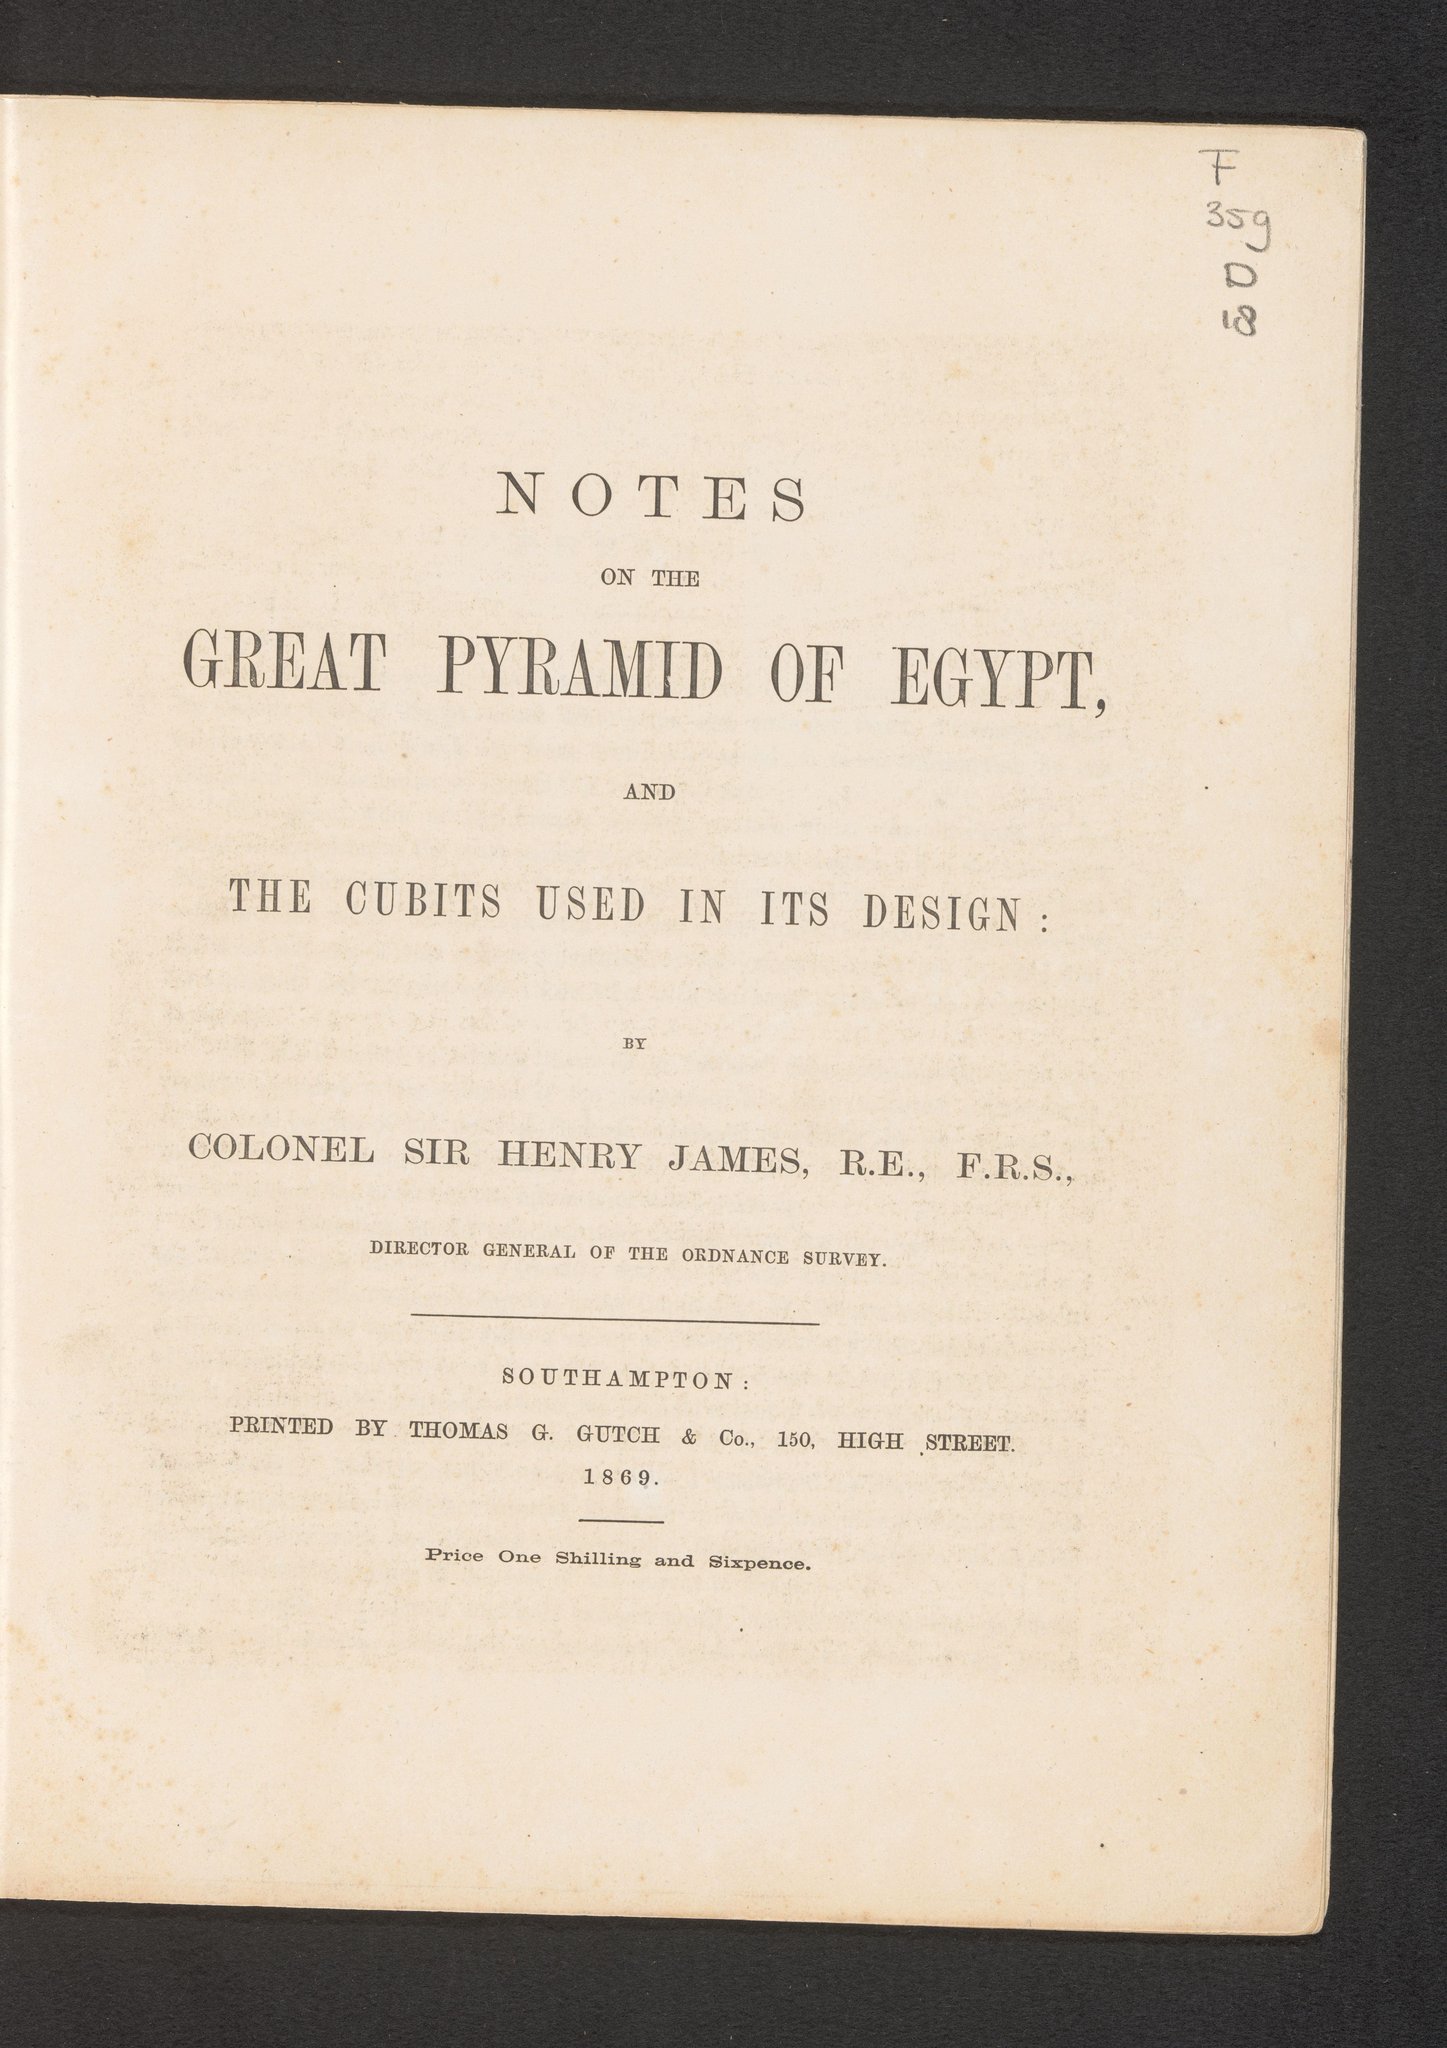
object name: book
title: Notes on the great pyramid of Egypt, and the cubits used in its design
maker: henry james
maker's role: schrijver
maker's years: 1843-1916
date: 1869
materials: paper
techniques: printing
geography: southampton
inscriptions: annotation: ‘JAN/ 1988’